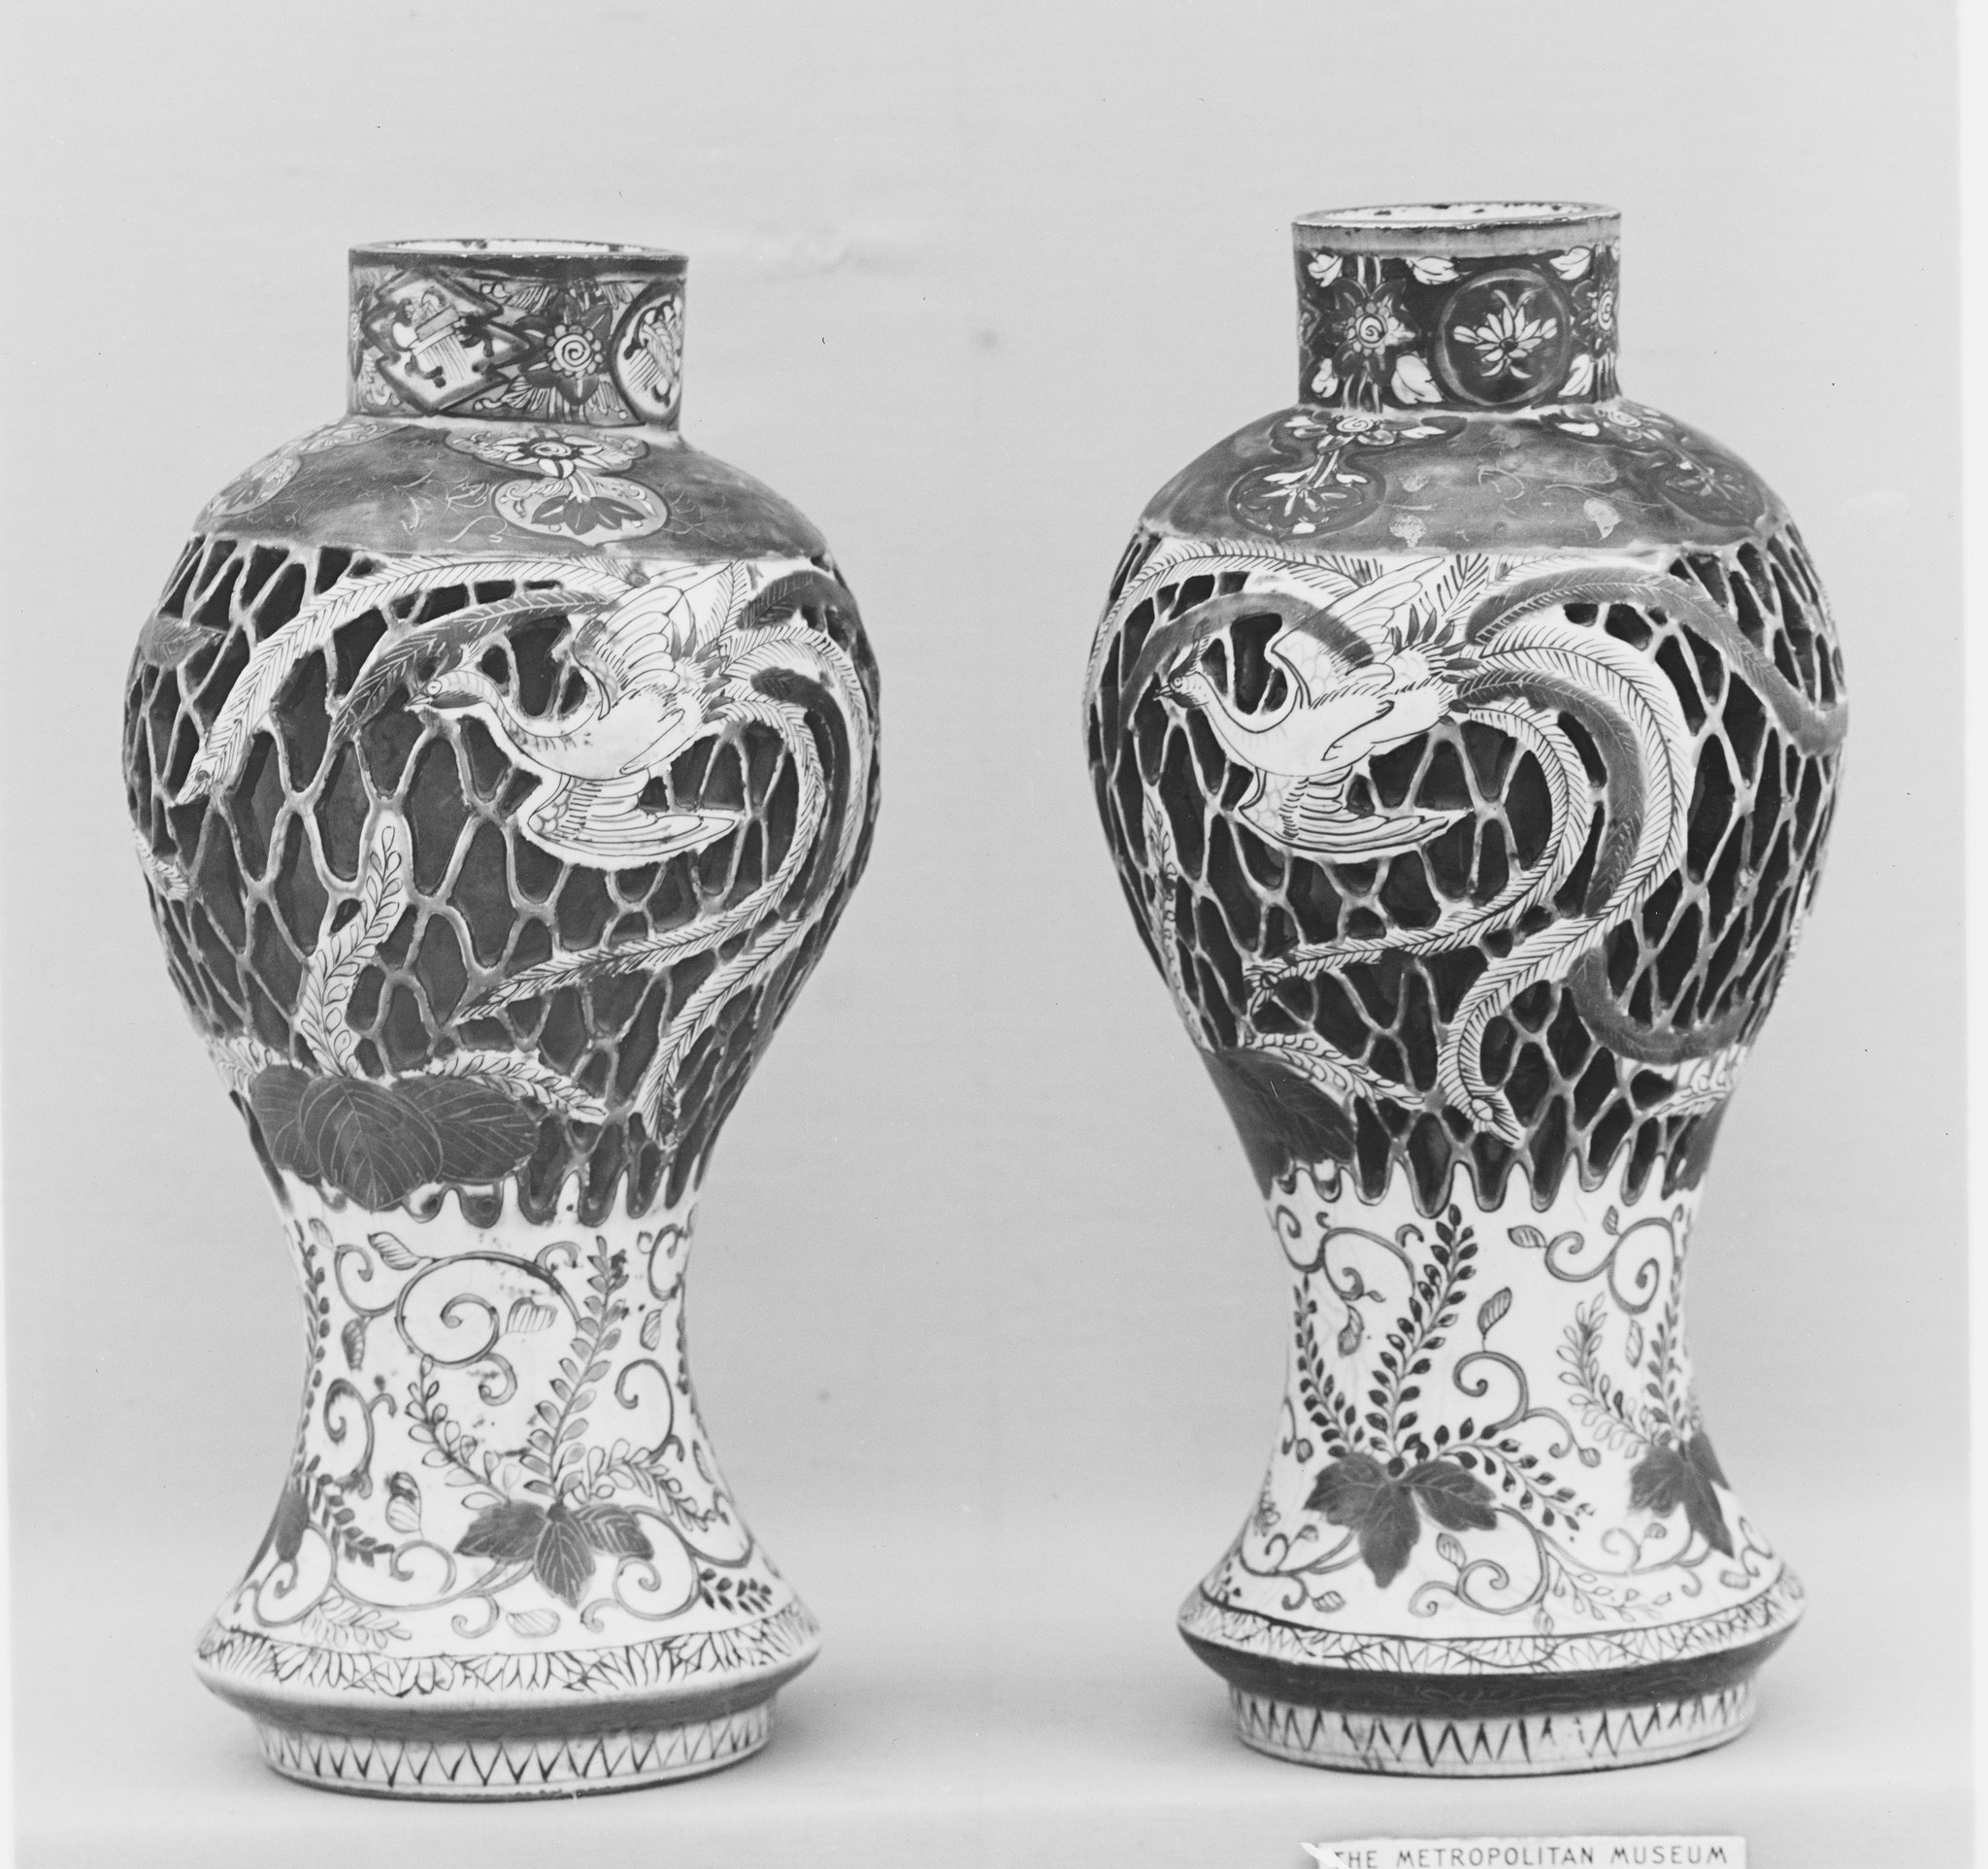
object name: vase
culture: japanese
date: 1664-1700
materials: gold, porcelain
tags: birds,flowers,leaves